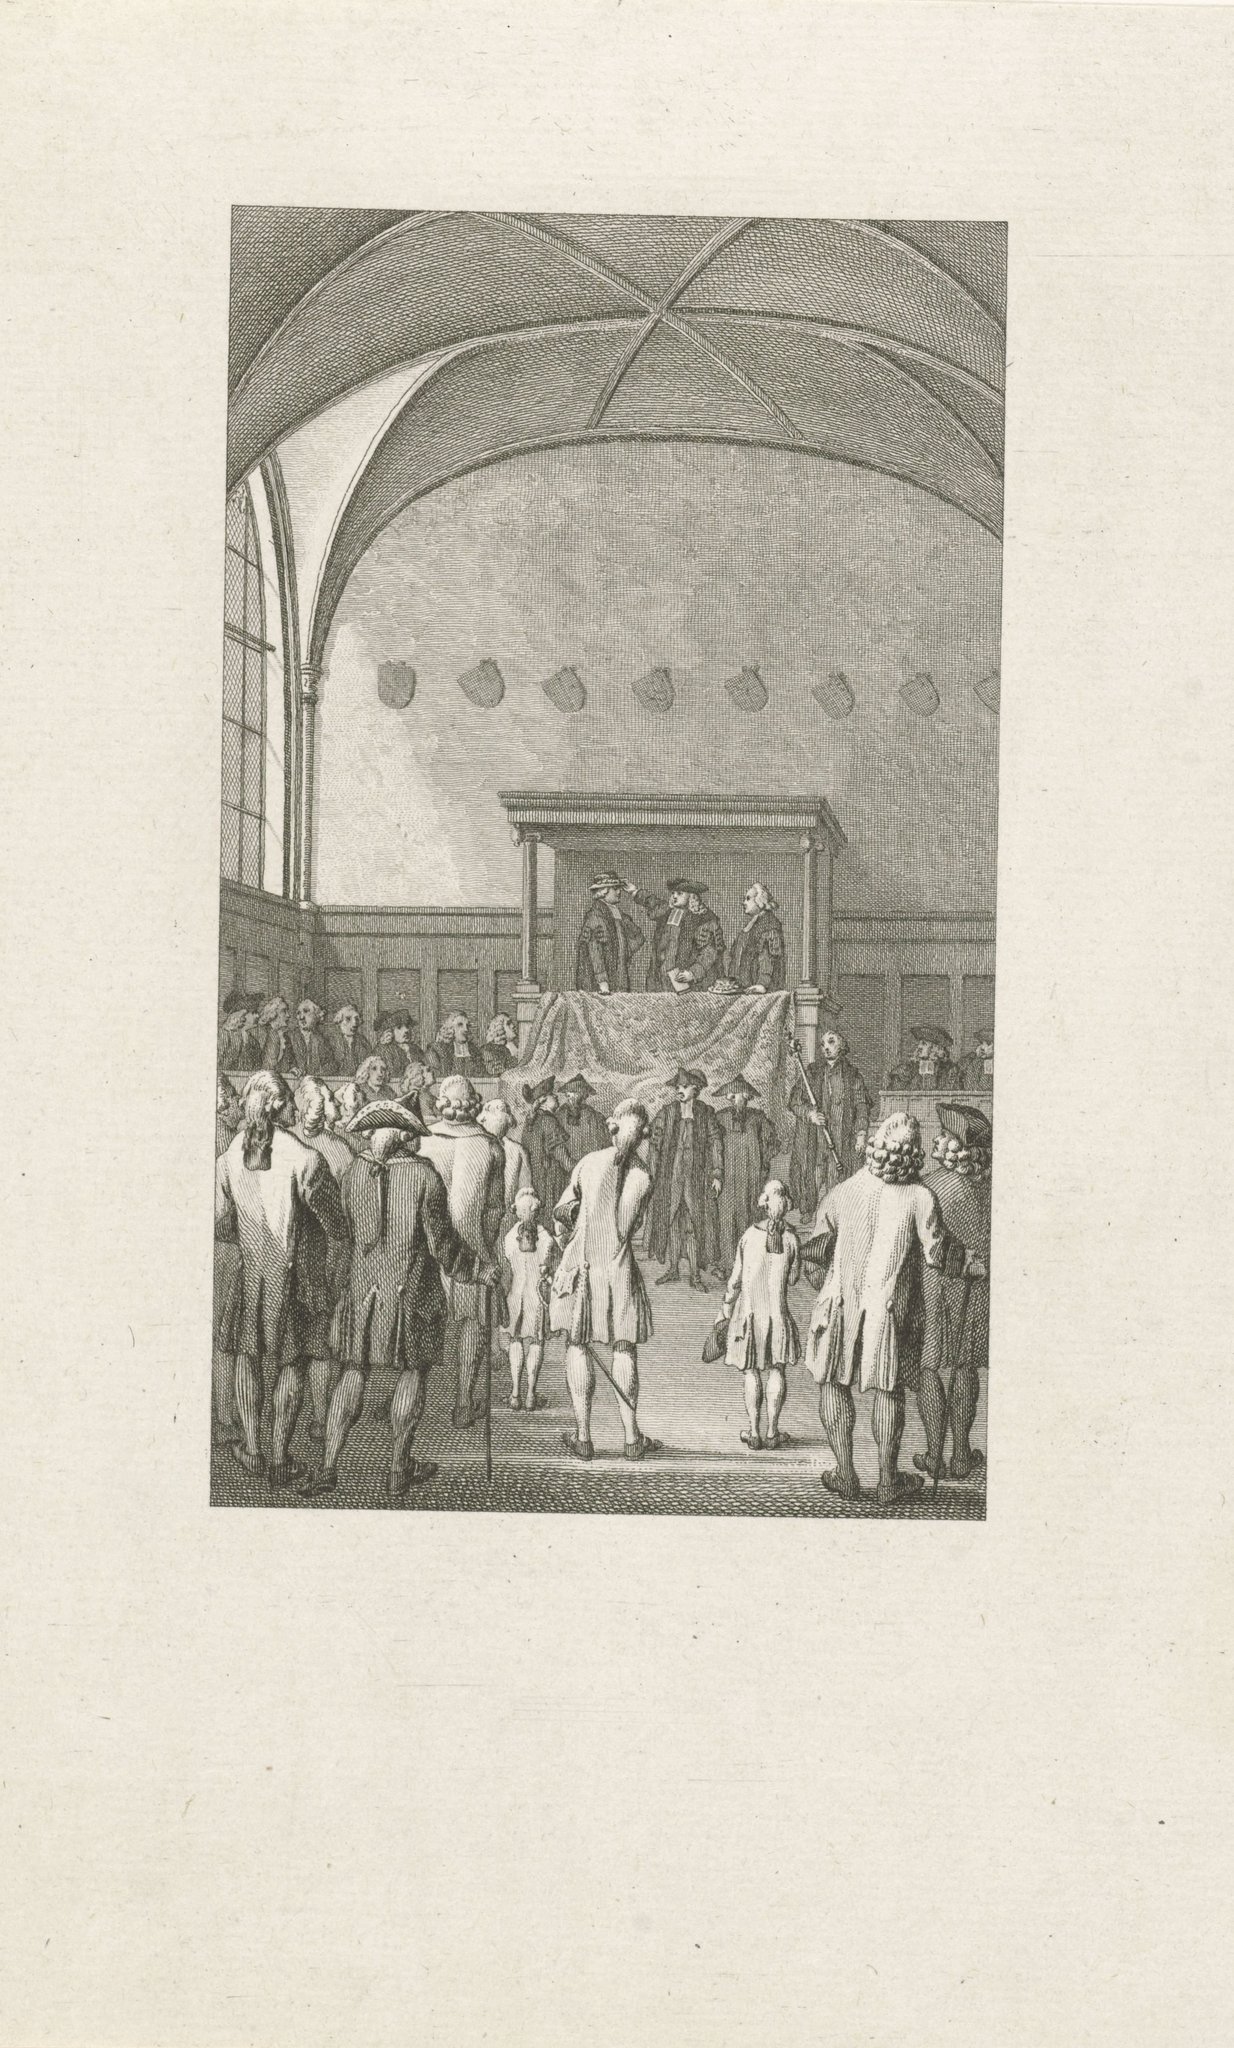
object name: print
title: Promotie met de kap, bij gelegenheid van het Tweede Eeuwfeest van de Leidse Hogeschool, 1775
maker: reinier vinkeles (i)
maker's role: draughtsman, print maker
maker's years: 1741-1816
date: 1775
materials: paper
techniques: engraving, etching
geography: northern netherlands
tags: receiving doctor's degree, commemoration of the founding of a university, leiden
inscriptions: collector's mark: Lugt 2228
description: Promotie met de kap in een universiteitszaal bij gelegenheid van het Tweede Eeuwfeest van de oprichting van de Universiteit van Leiden, 9 februari 1775.